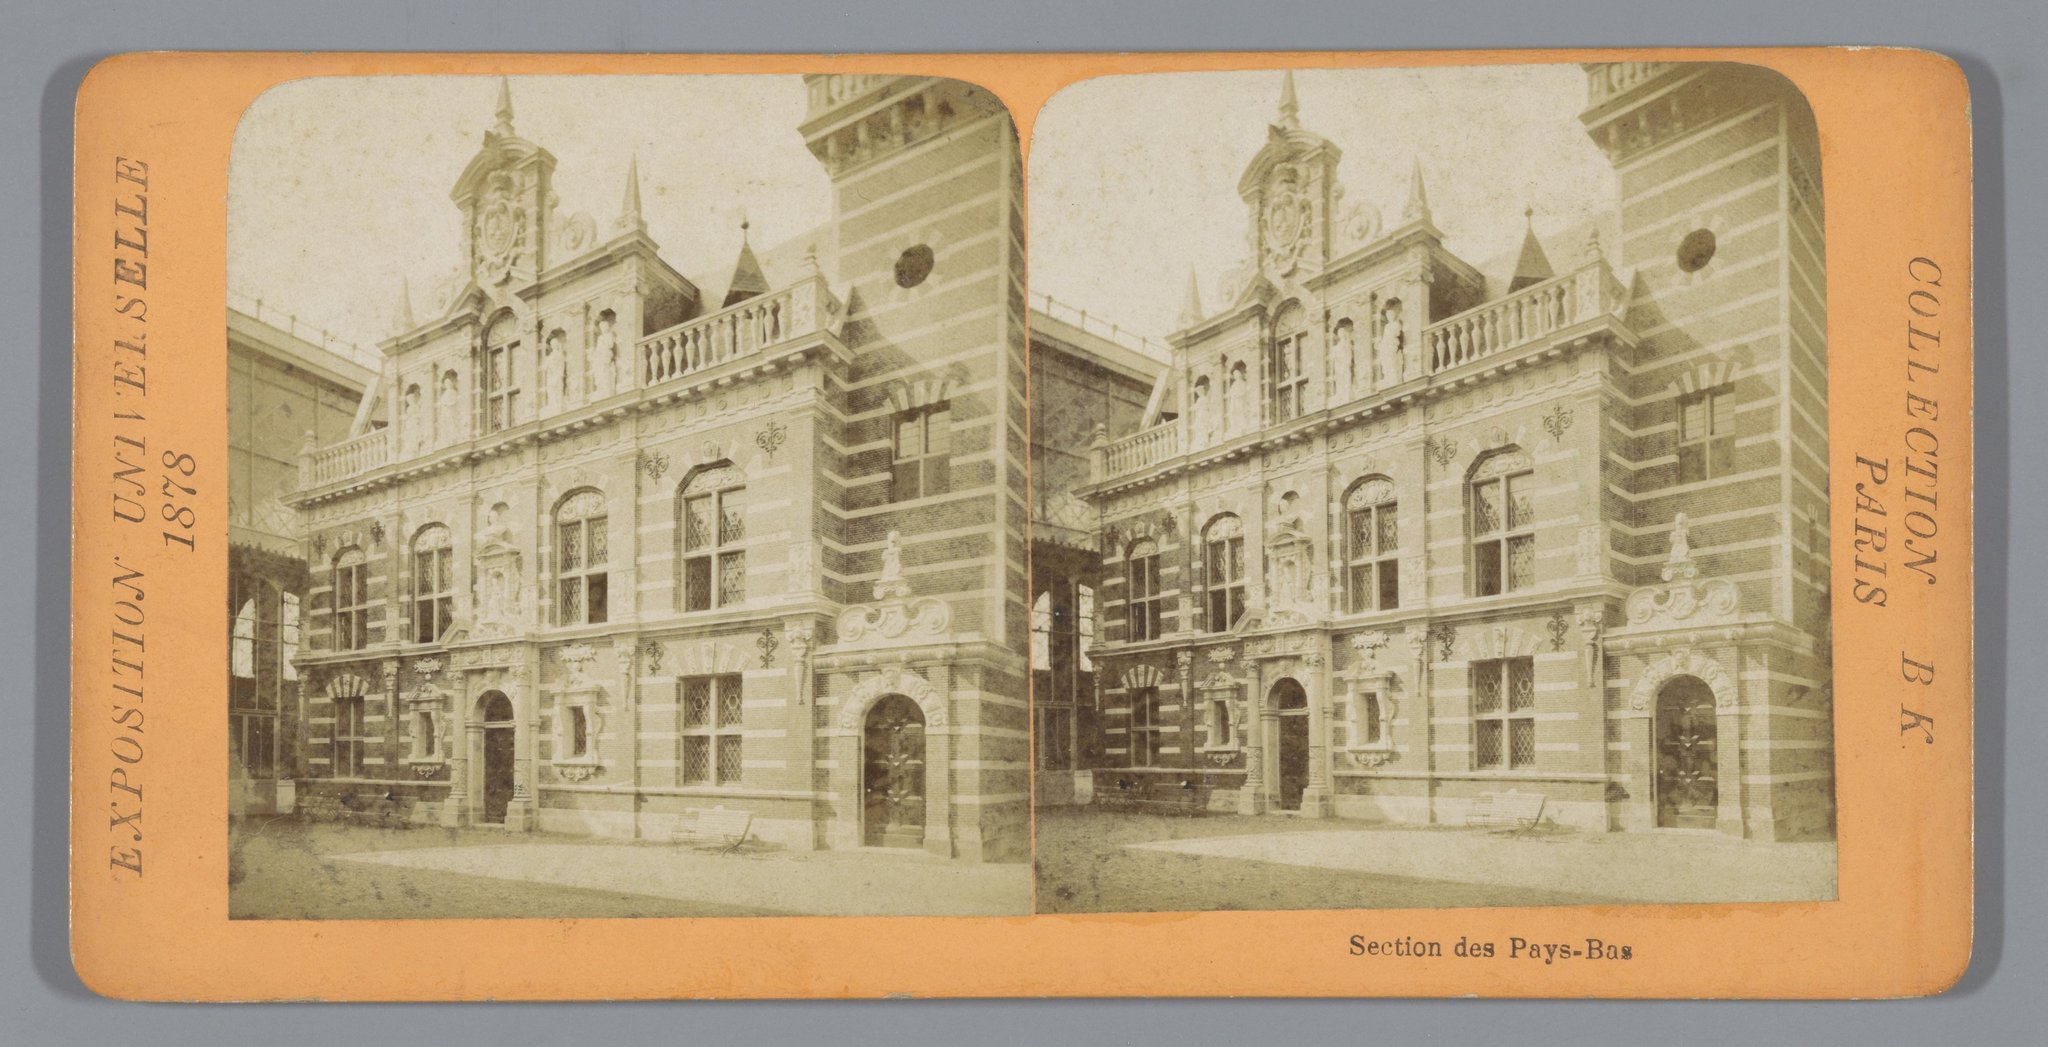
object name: stereograph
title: Section des Pays-Bas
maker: adolphe block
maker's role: publisher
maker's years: 1829-1918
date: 1878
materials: cardboard, paper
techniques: albumen print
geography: paris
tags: world fair, world exhibition, exterior ~ representation of a building, paris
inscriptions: inscription: ‘Nederland/ Gebouw’